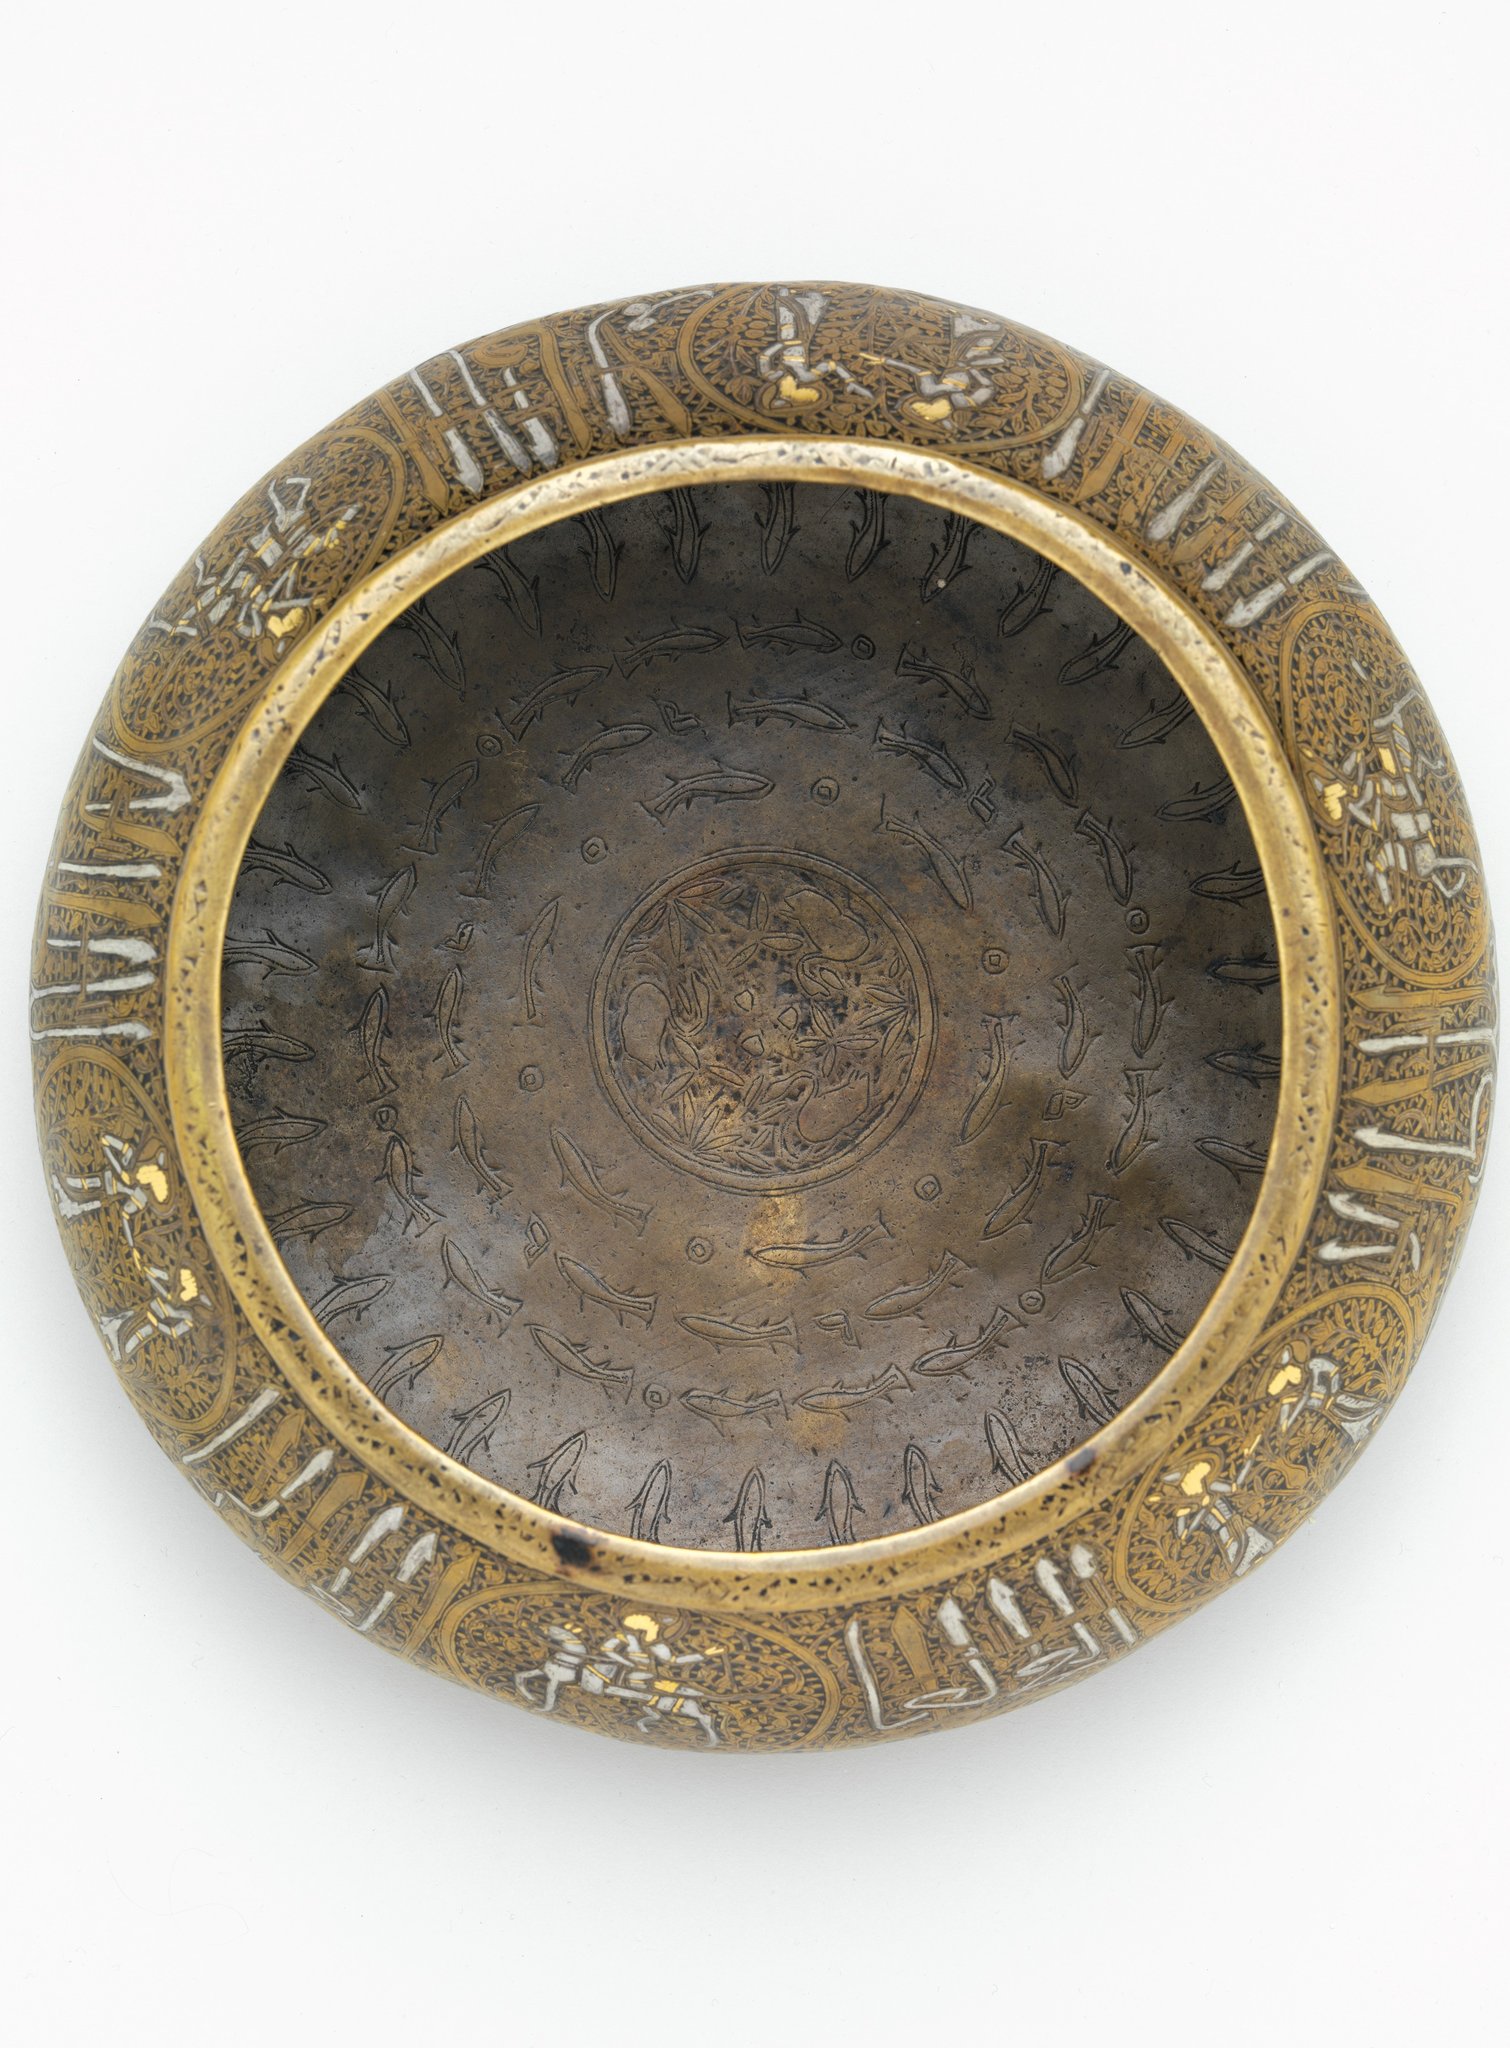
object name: bowl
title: Bowl with Figural Imagery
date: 1351-1400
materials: brass, gold, silver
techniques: engraving, hammering, inlay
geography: iran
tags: human figures,horses